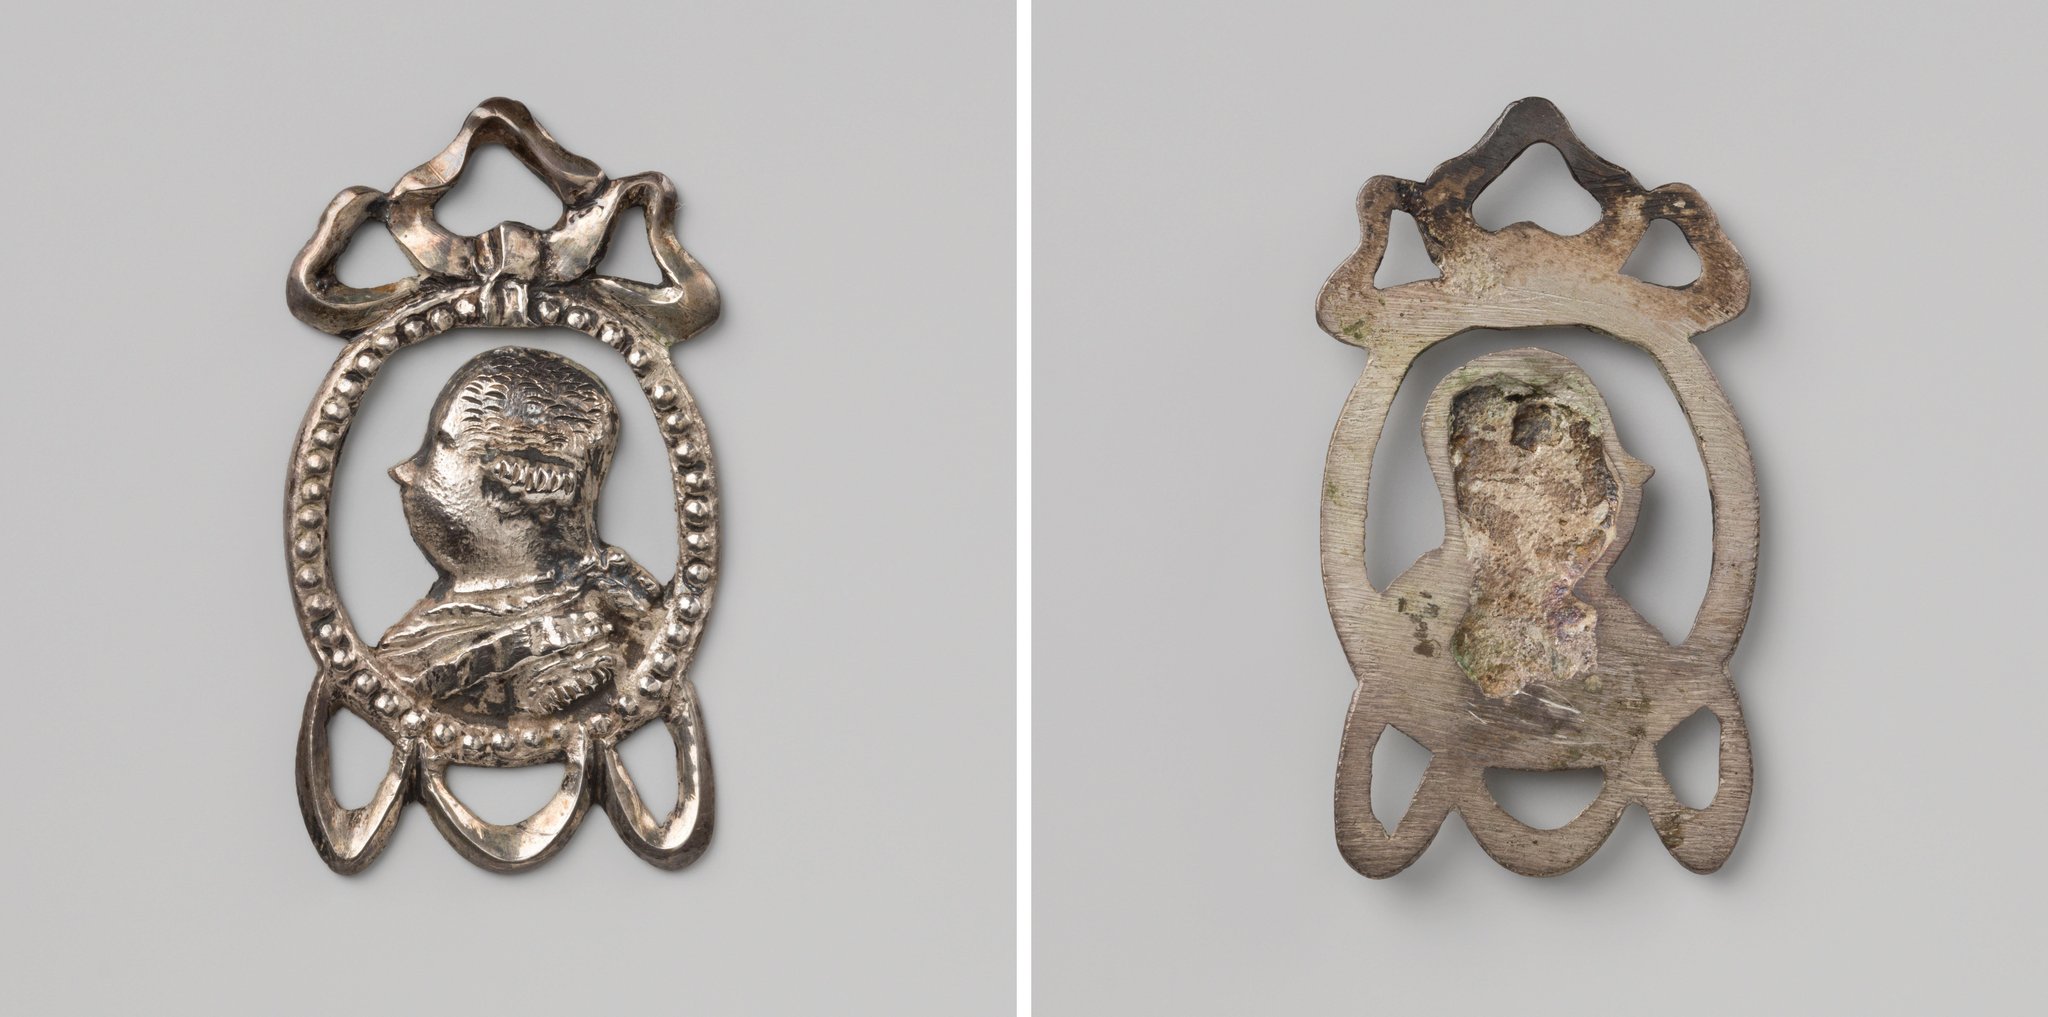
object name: insignia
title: Willem V, prins van Oranje-Nassau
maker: Anonymous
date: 1787-1795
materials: textile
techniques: casting, embroidery, silvering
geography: netherlands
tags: the hague, william v (prince of orange)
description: eenzijdig, ovaal, opengewerkt draagteken met aan boven- en onderzijde lussen en bijbehorend geel-verkleurd lint. Voorzijde: borststuk man binnen rand met oranjeappels